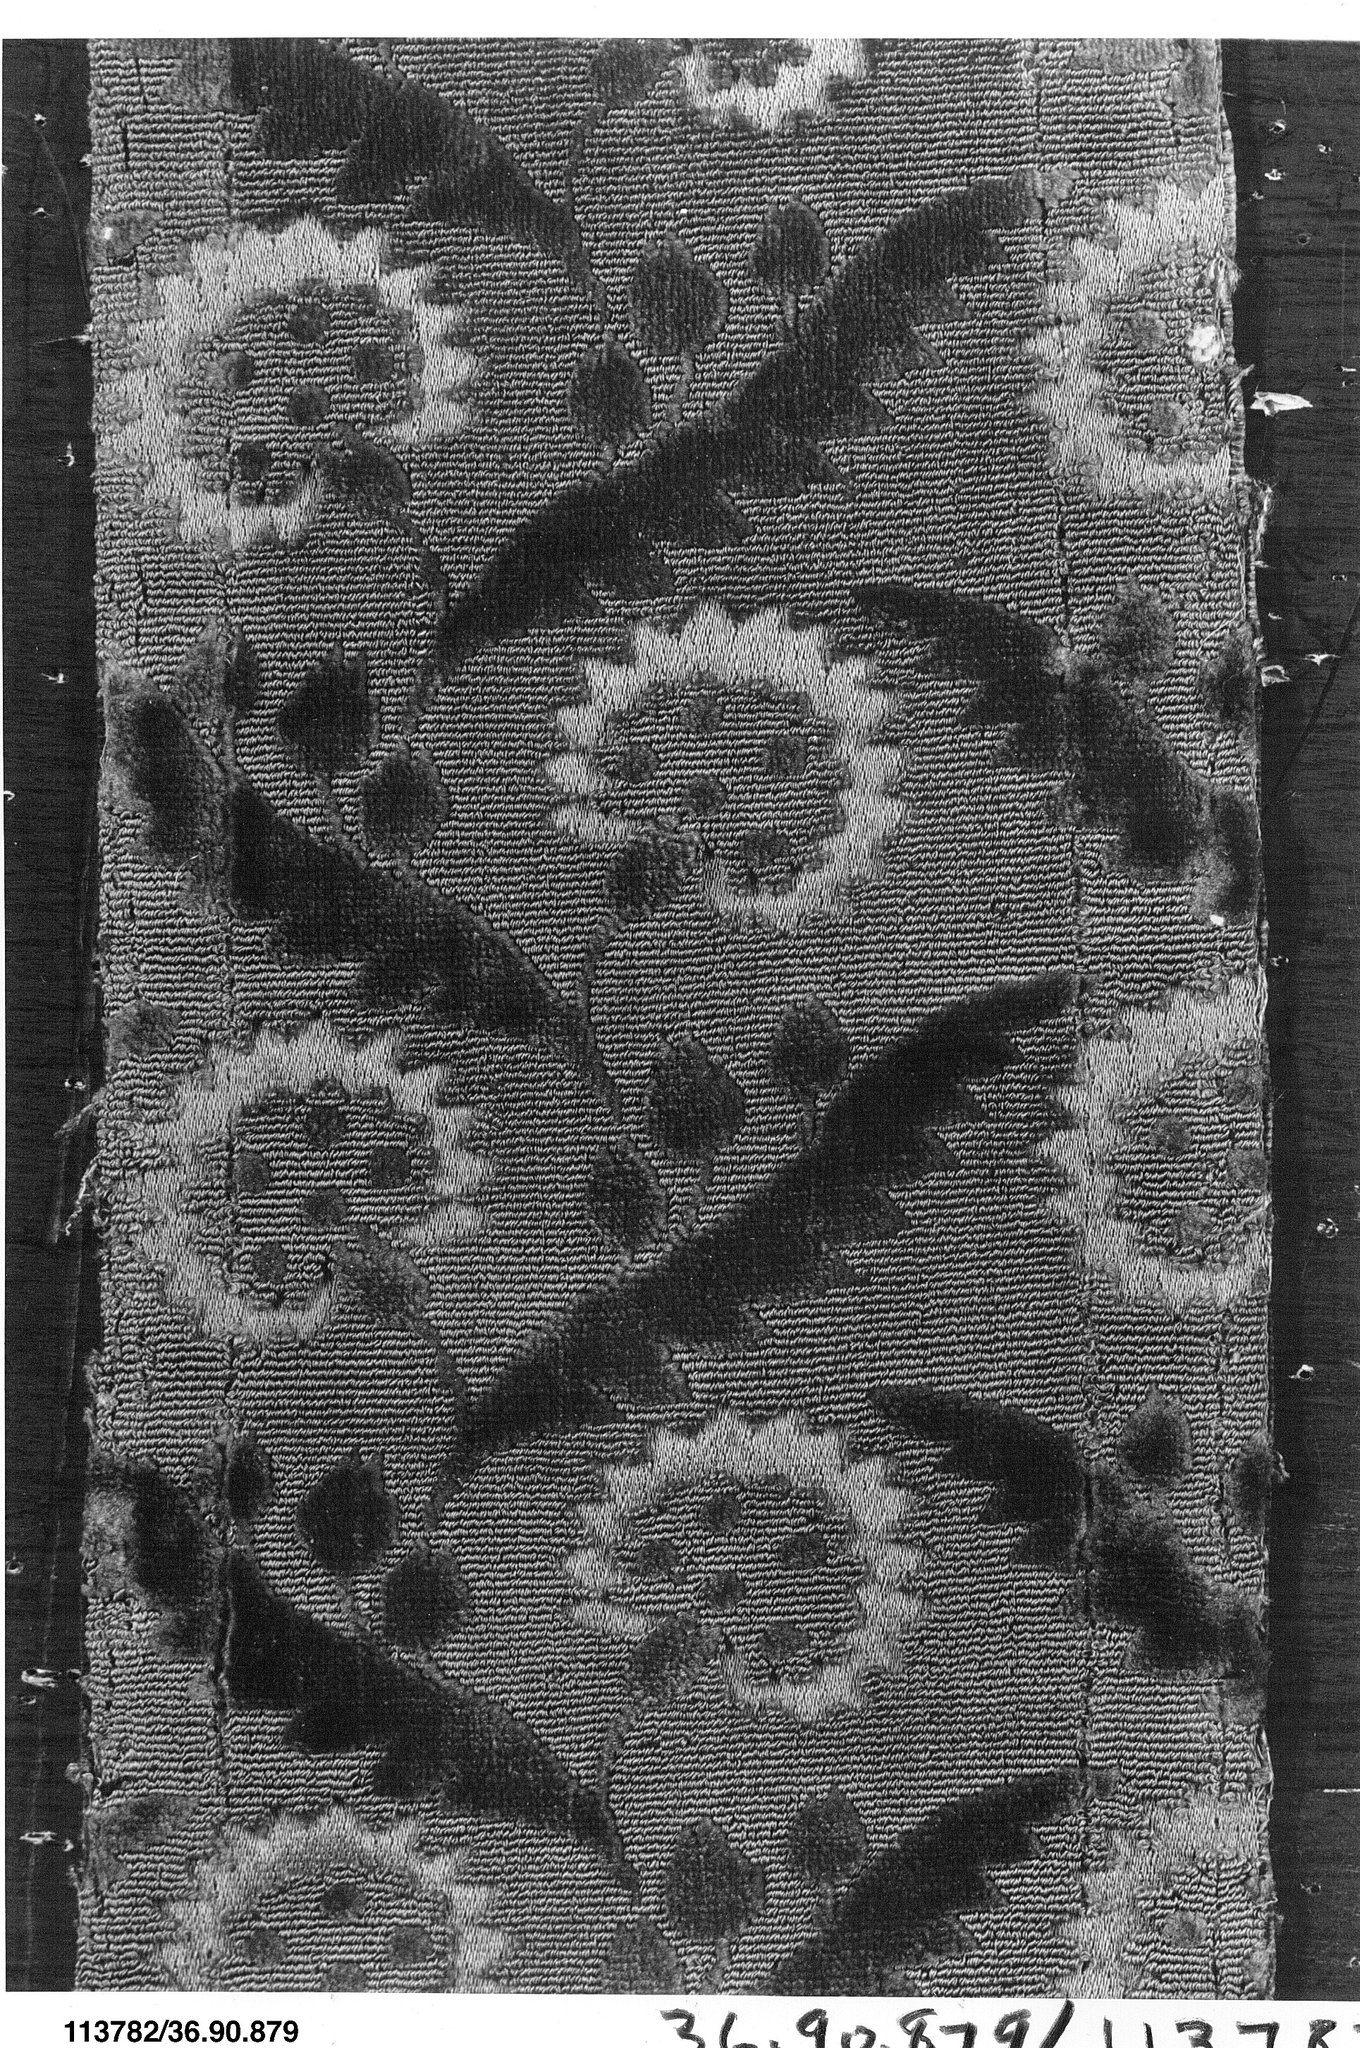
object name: piece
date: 1701-1800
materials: silk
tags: flowers,leaves